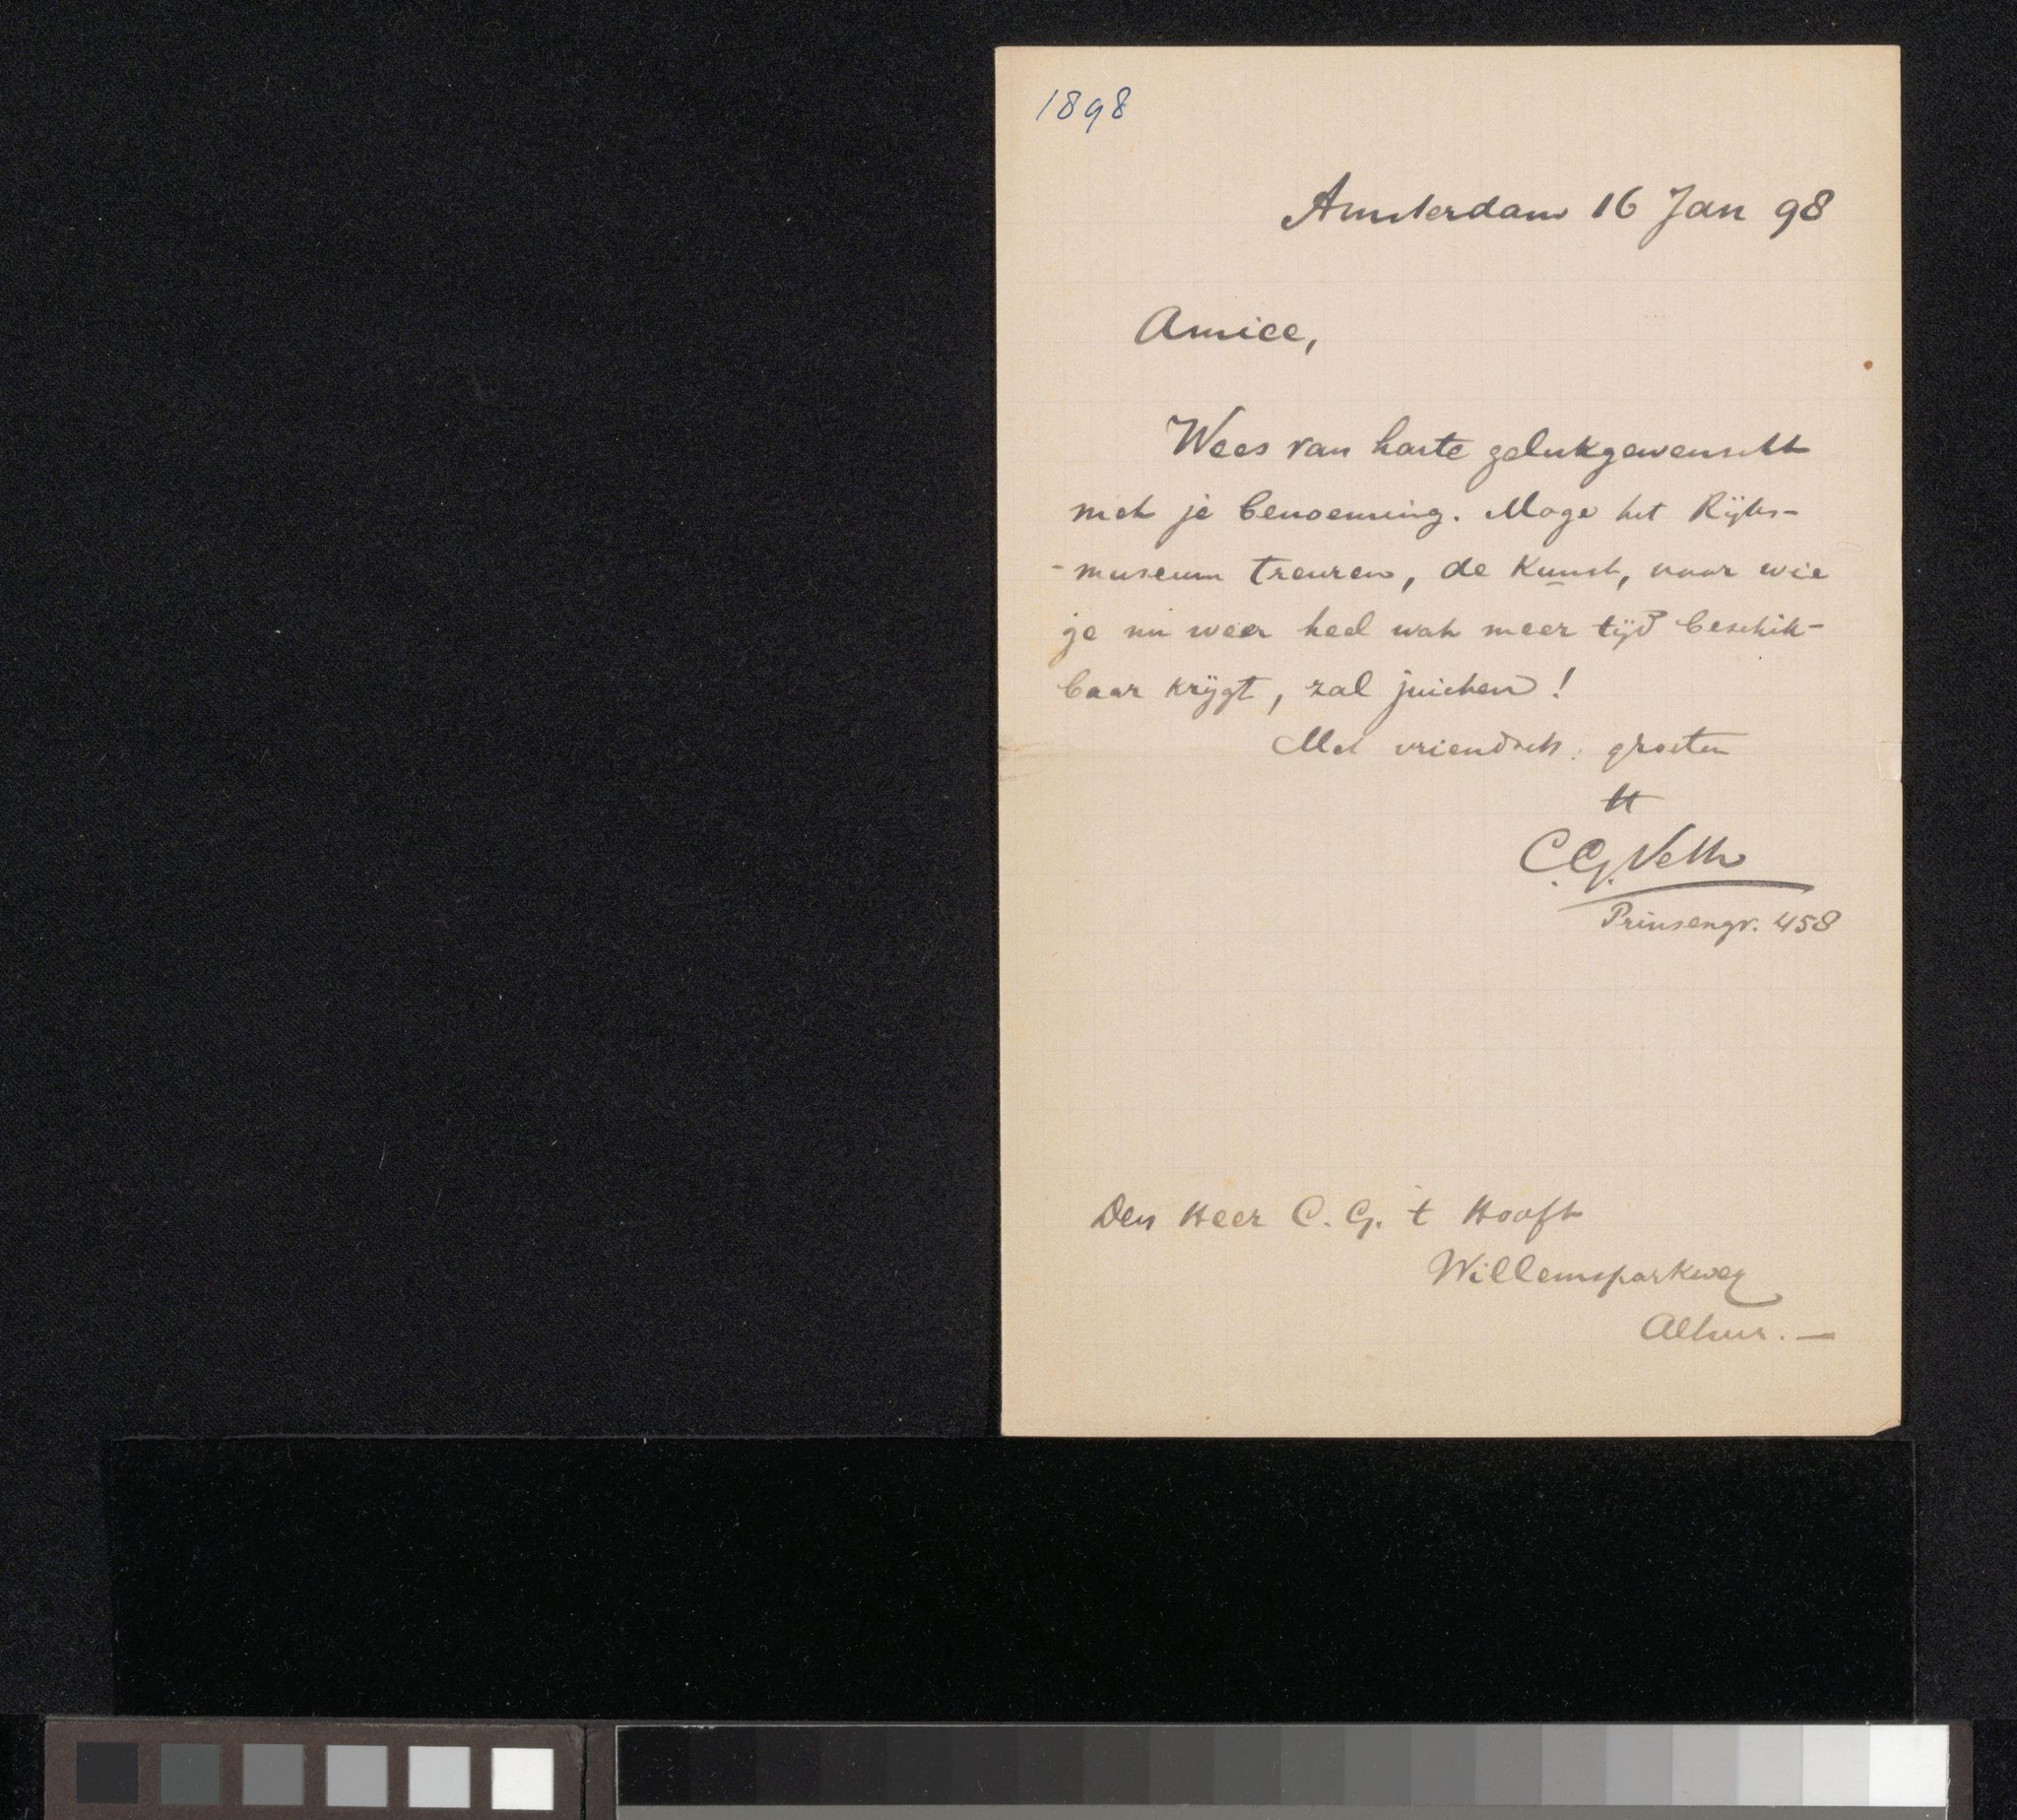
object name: letter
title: Brief aan Cornelis Gerardus 't Hooft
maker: cornelis giltay veth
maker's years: 1861-1942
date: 1898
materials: ink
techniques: pen, writing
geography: amsterdam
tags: amsterdam, painter, draughtsman, cornelis gerardus 't hooft, rijksmuseum amsterdam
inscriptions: collector's mark: ‘RPK’